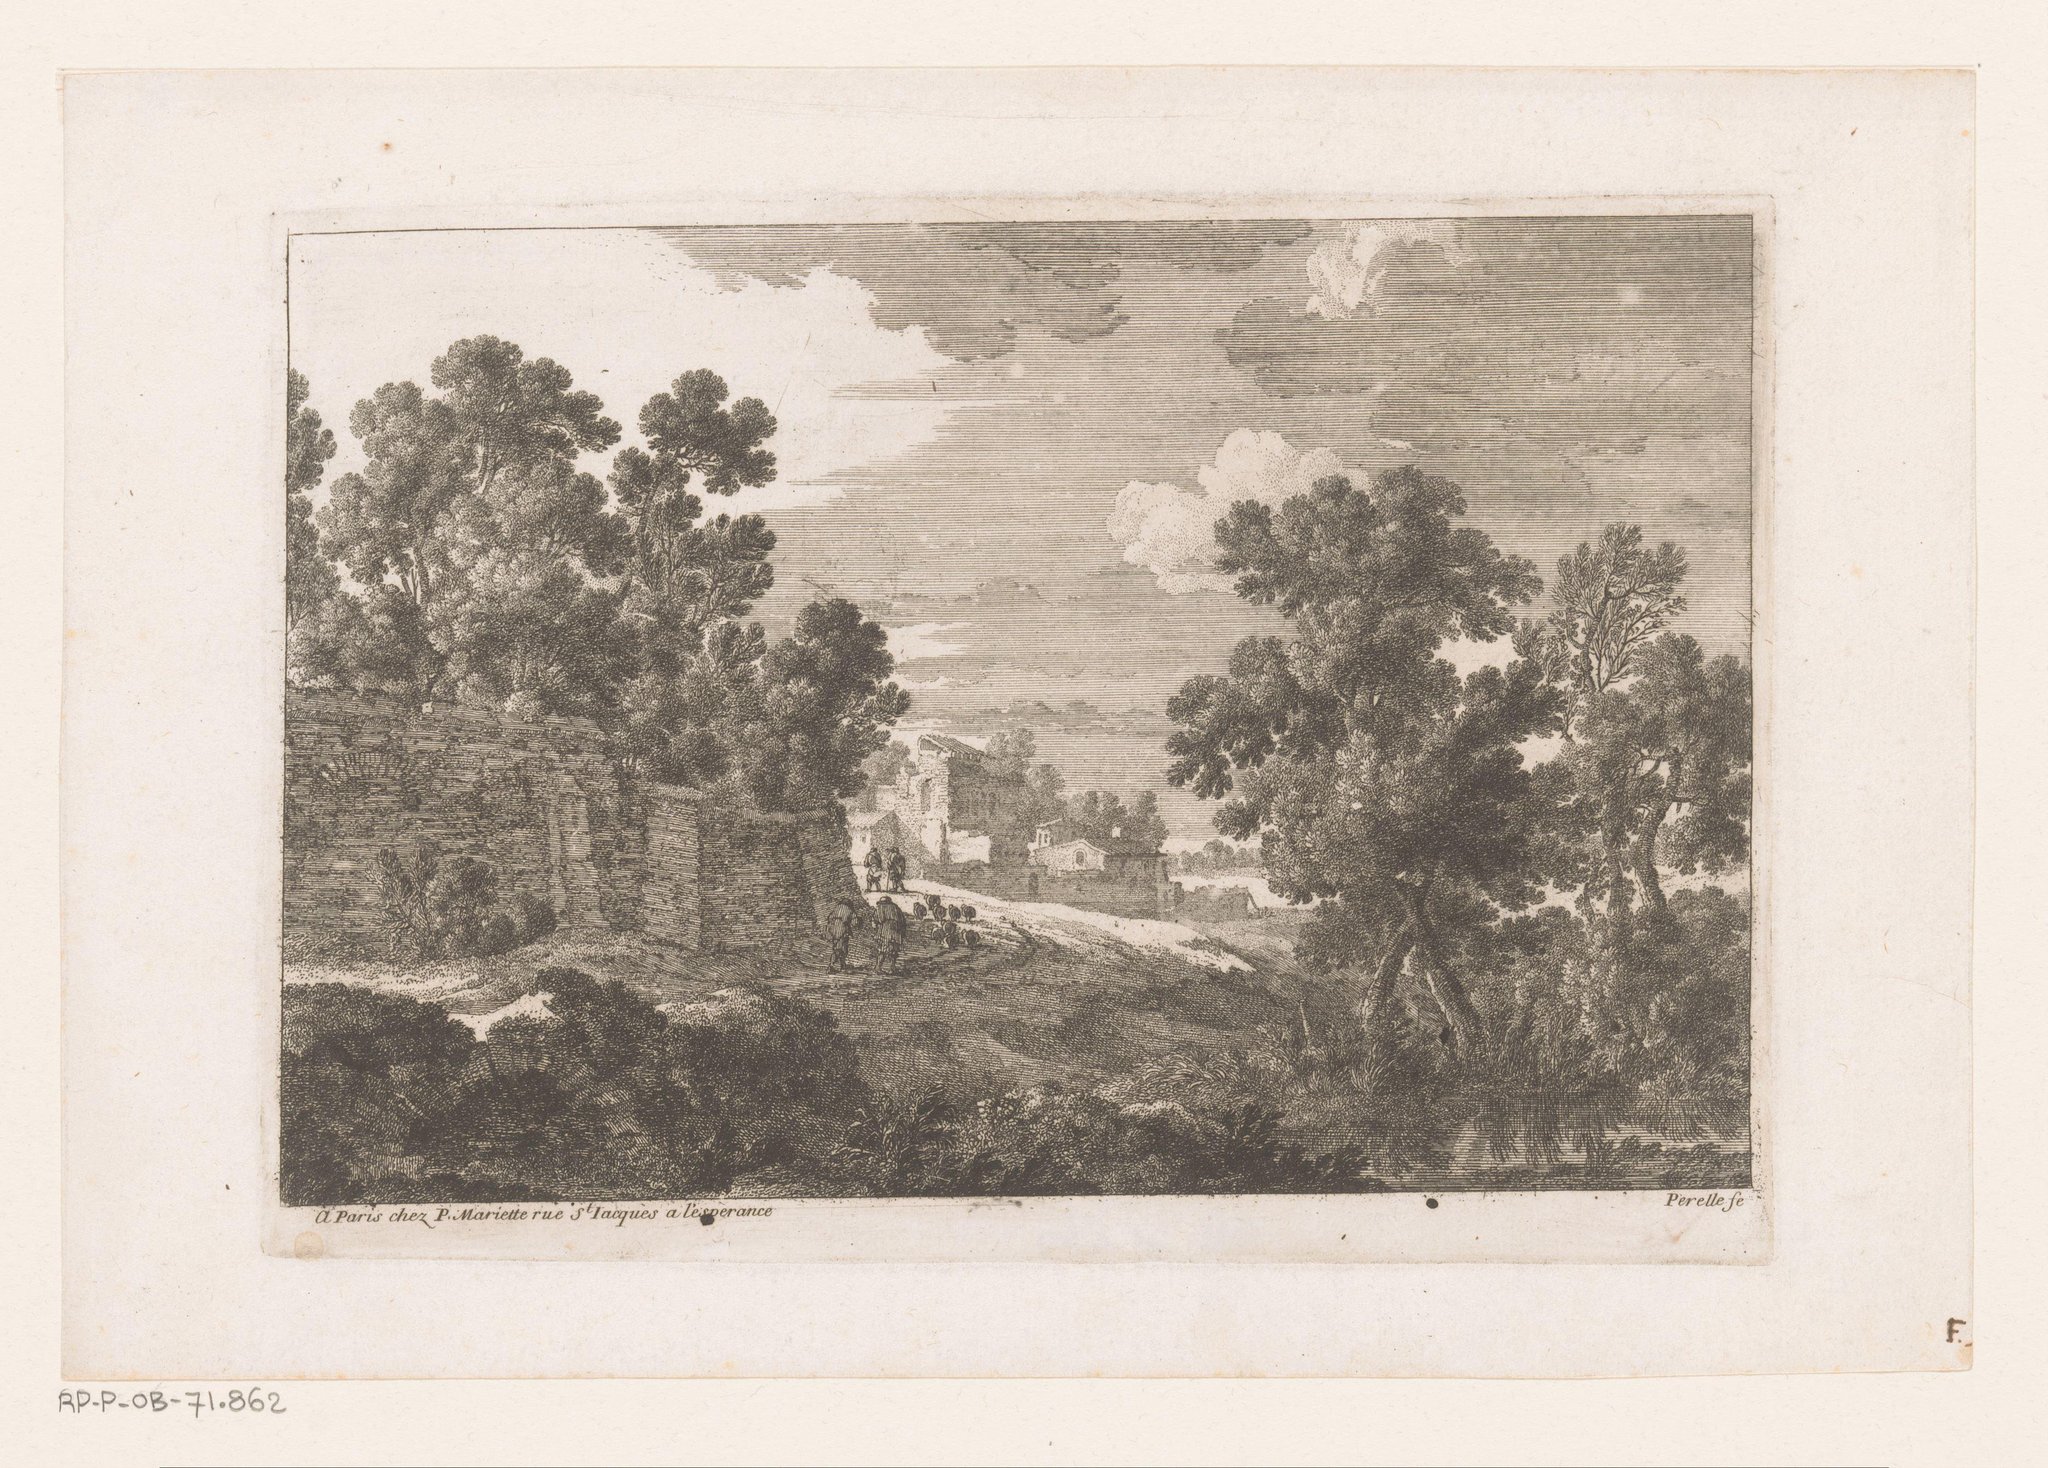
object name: print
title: Herders op pad langs muur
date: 1613-1695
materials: paper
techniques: engraving, etching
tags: landscapes, herding, herdsman, herdswoman, shepherd, shepherdess, cowherd, etc., road, path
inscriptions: collector's mark: Lugt 240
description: Prenten met het signatuur 'Perelle' kunnen zowel door vader Gabriel als door zonen Nicolas en Adam gemaakt zijn.